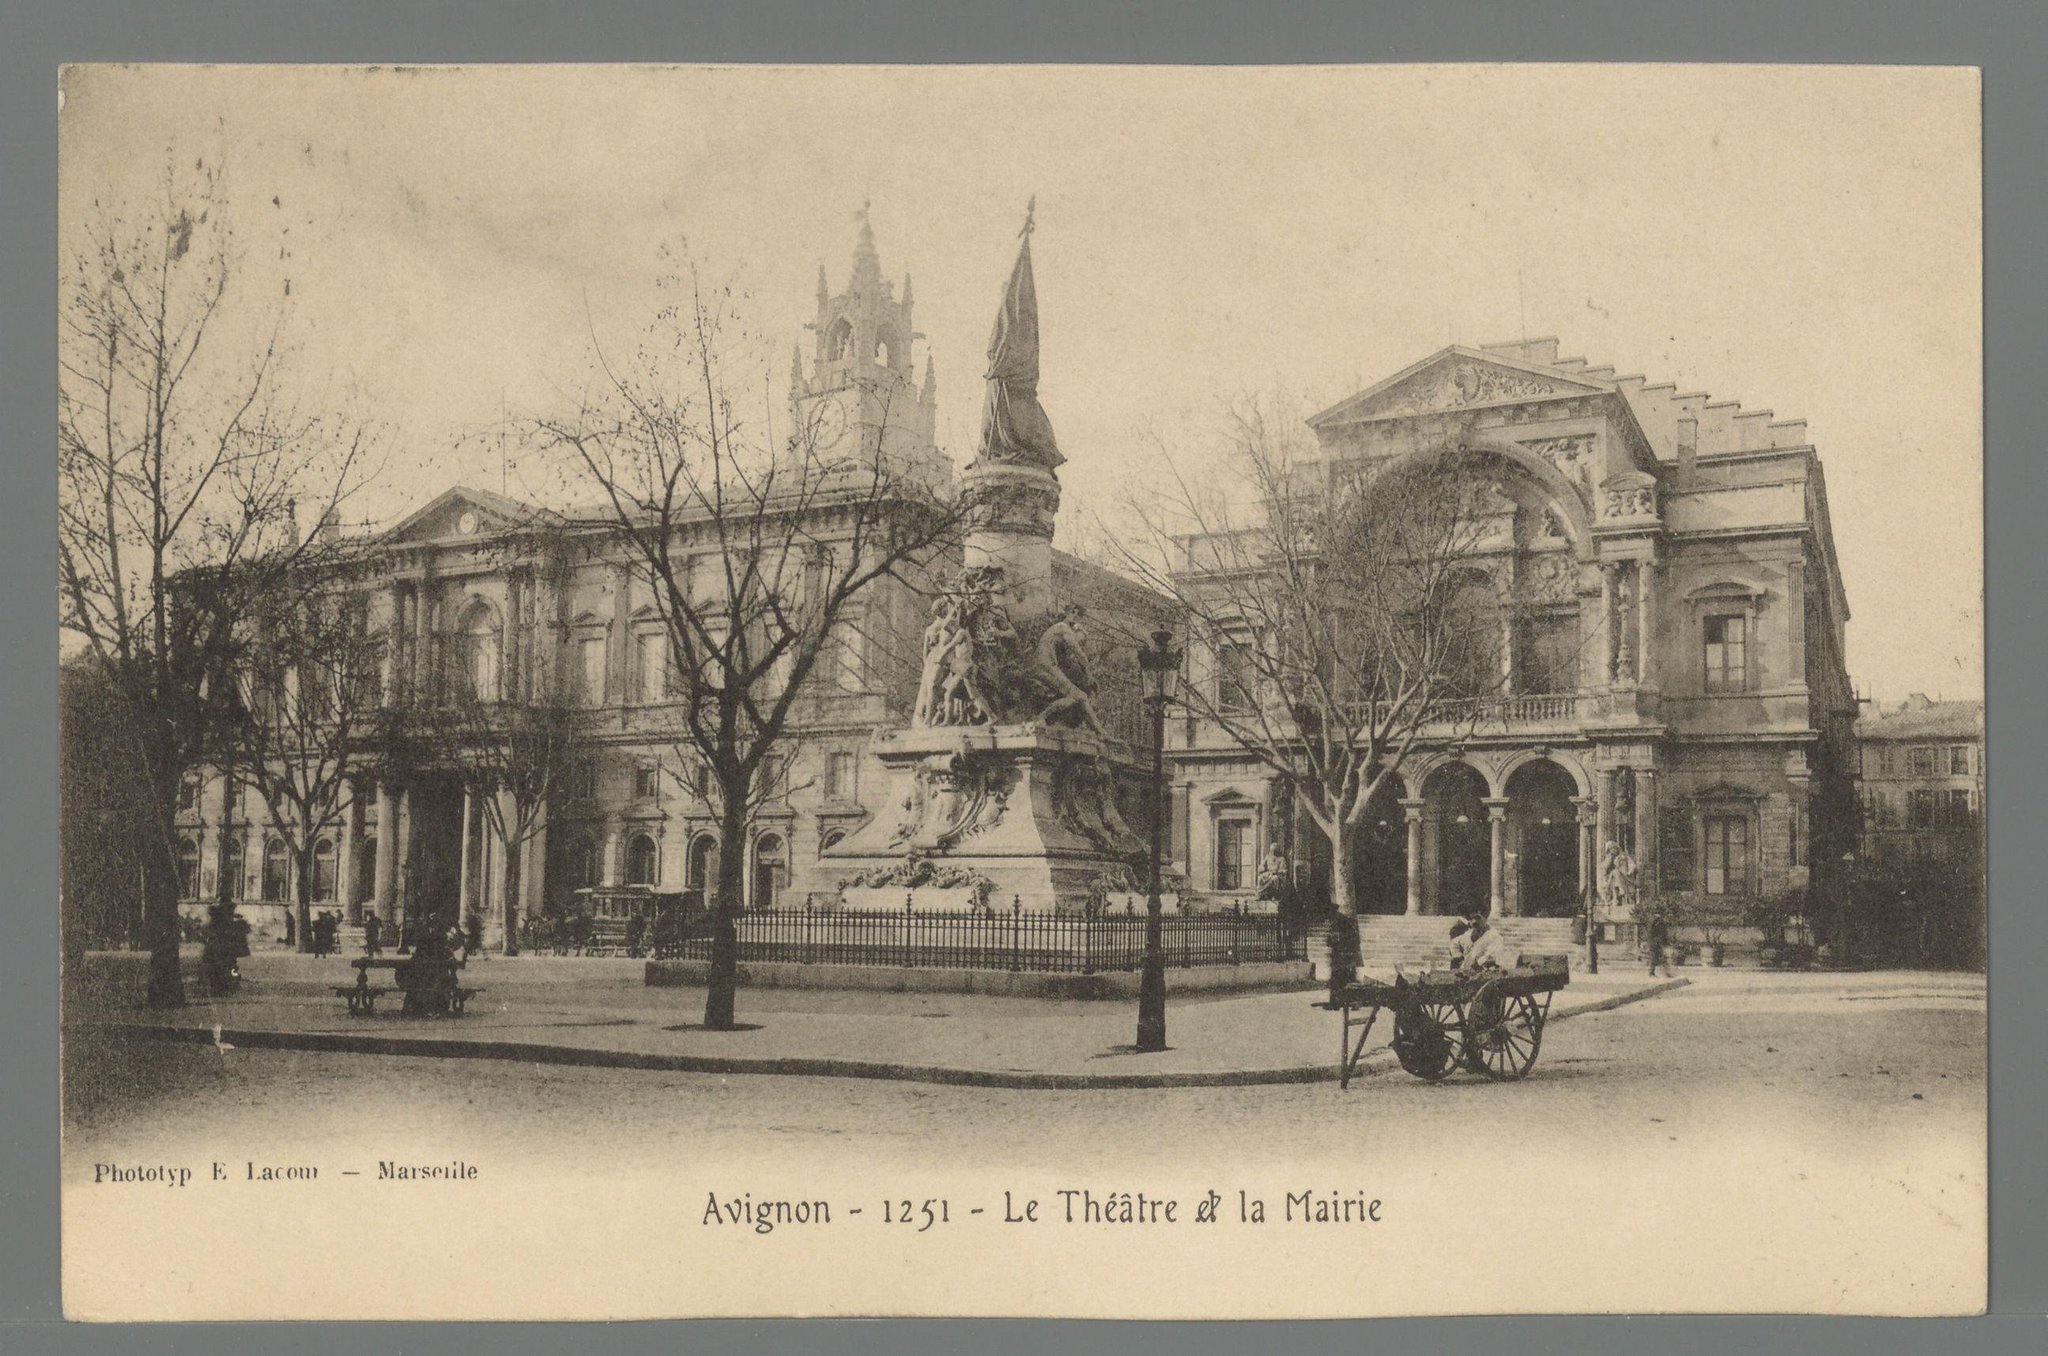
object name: photomechanical print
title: Avignon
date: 1892-1903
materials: cardboard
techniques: photograph, writing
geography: marseille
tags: square, place, circus, etc., theatre (building), townhall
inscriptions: poststempel, verso, gestempeld